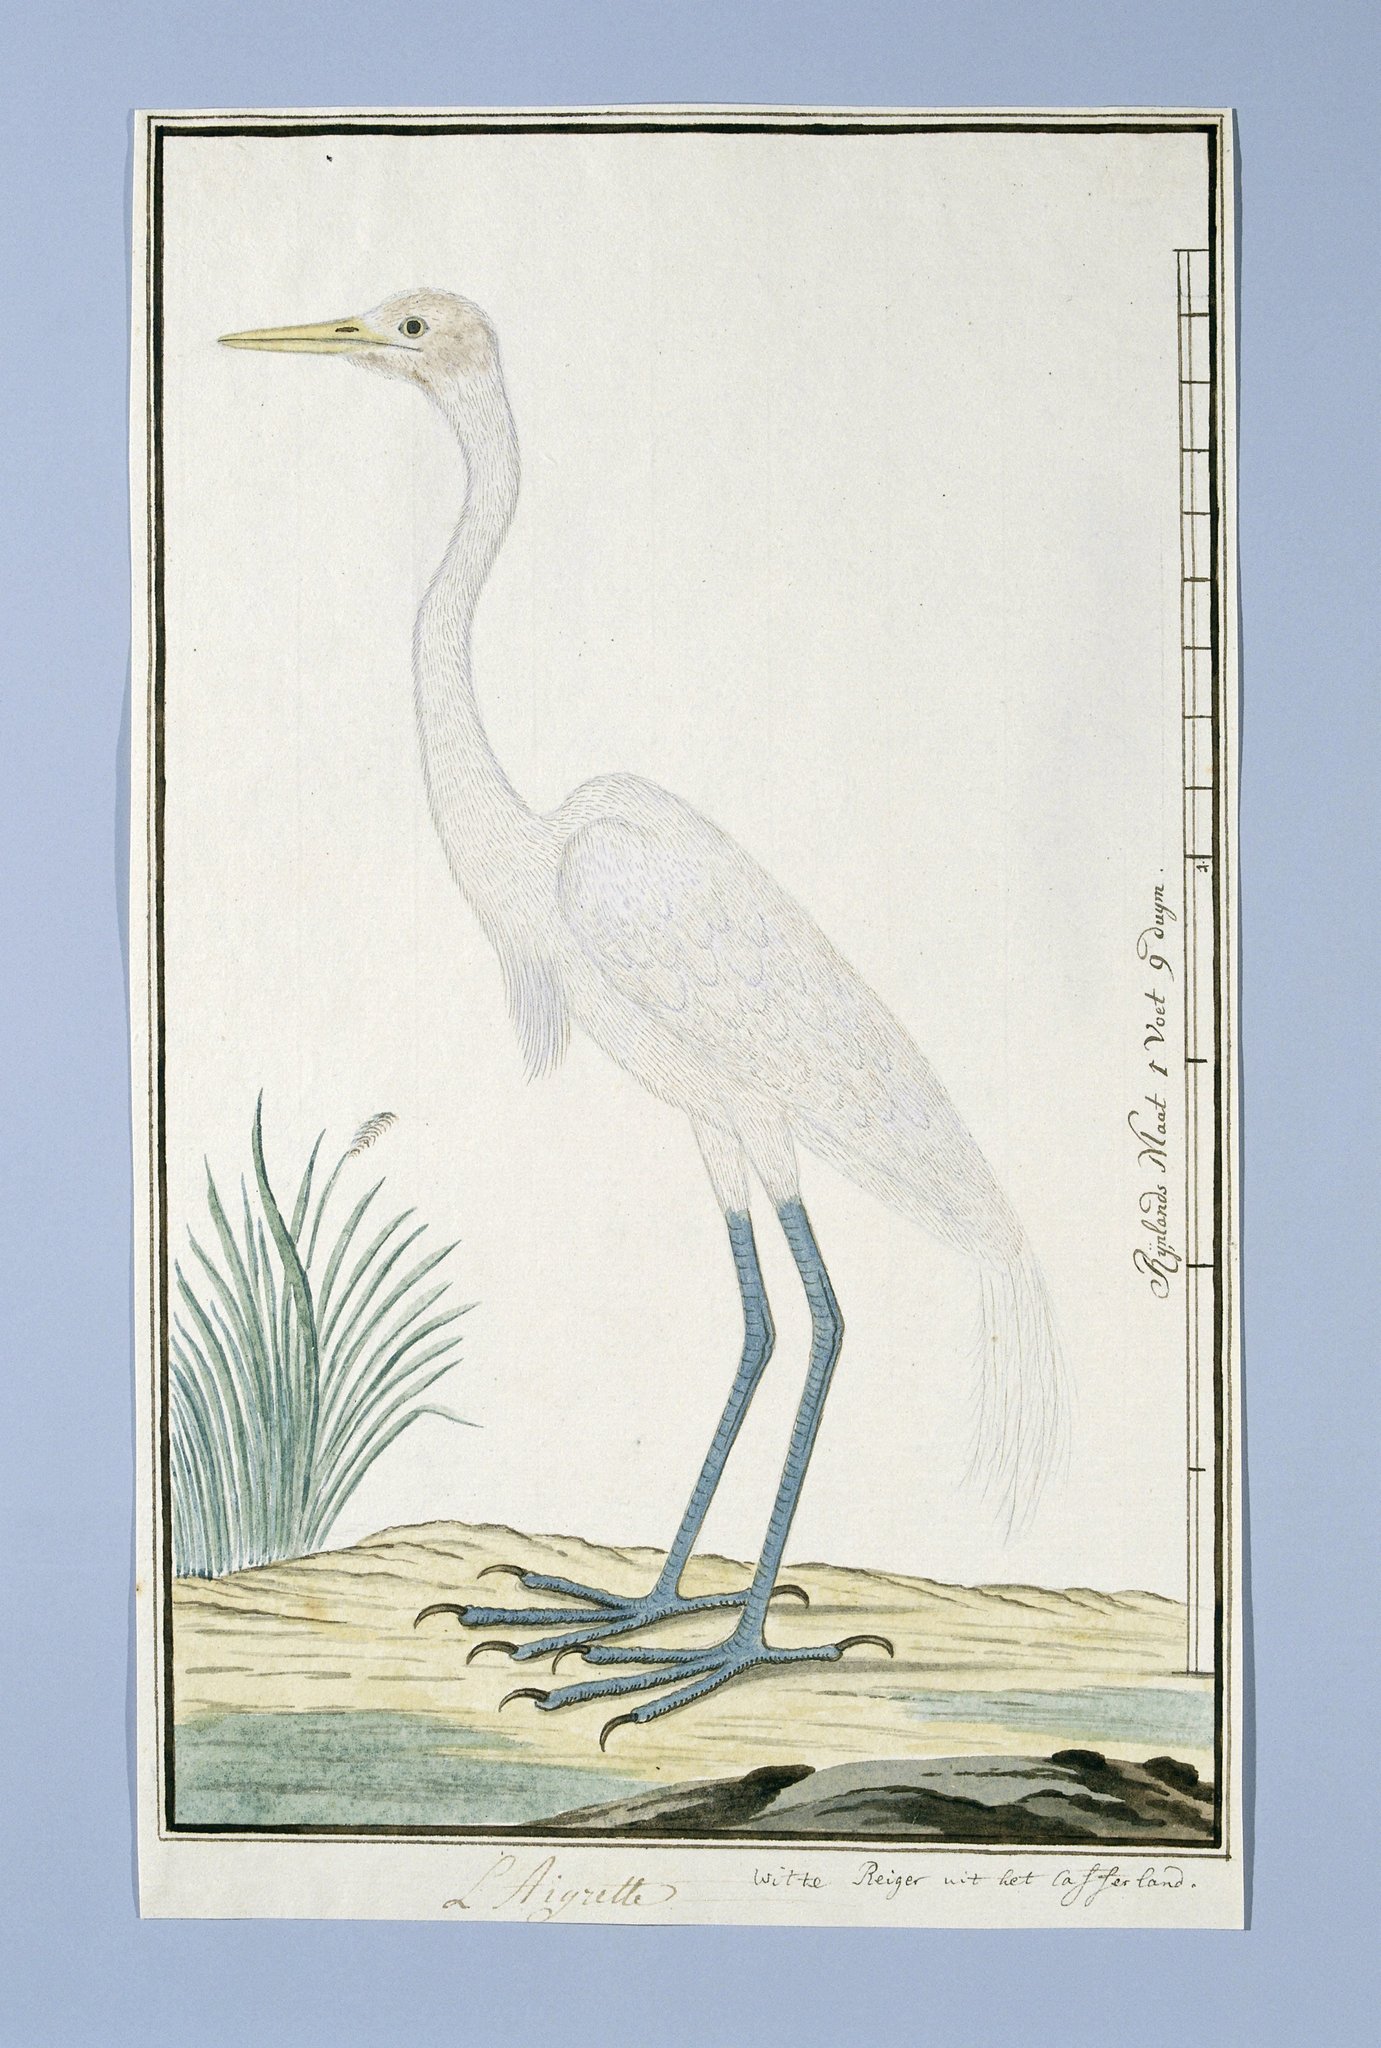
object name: drawing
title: Ardea alba (Great egret)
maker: robert jacob gordon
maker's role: draughtsman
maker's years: 1743-1795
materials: chalk, ink, paper, pencil, watercolor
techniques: brush, pen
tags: shore-birds and wading-birds: heron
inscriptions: annotation: ‘Witte Reiger uit het Cafferland; L Aigrette’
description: Vogelstudie: Geelsnavelreiger (Egretta alba); met schaalverdeling in Rijnlandse maat.